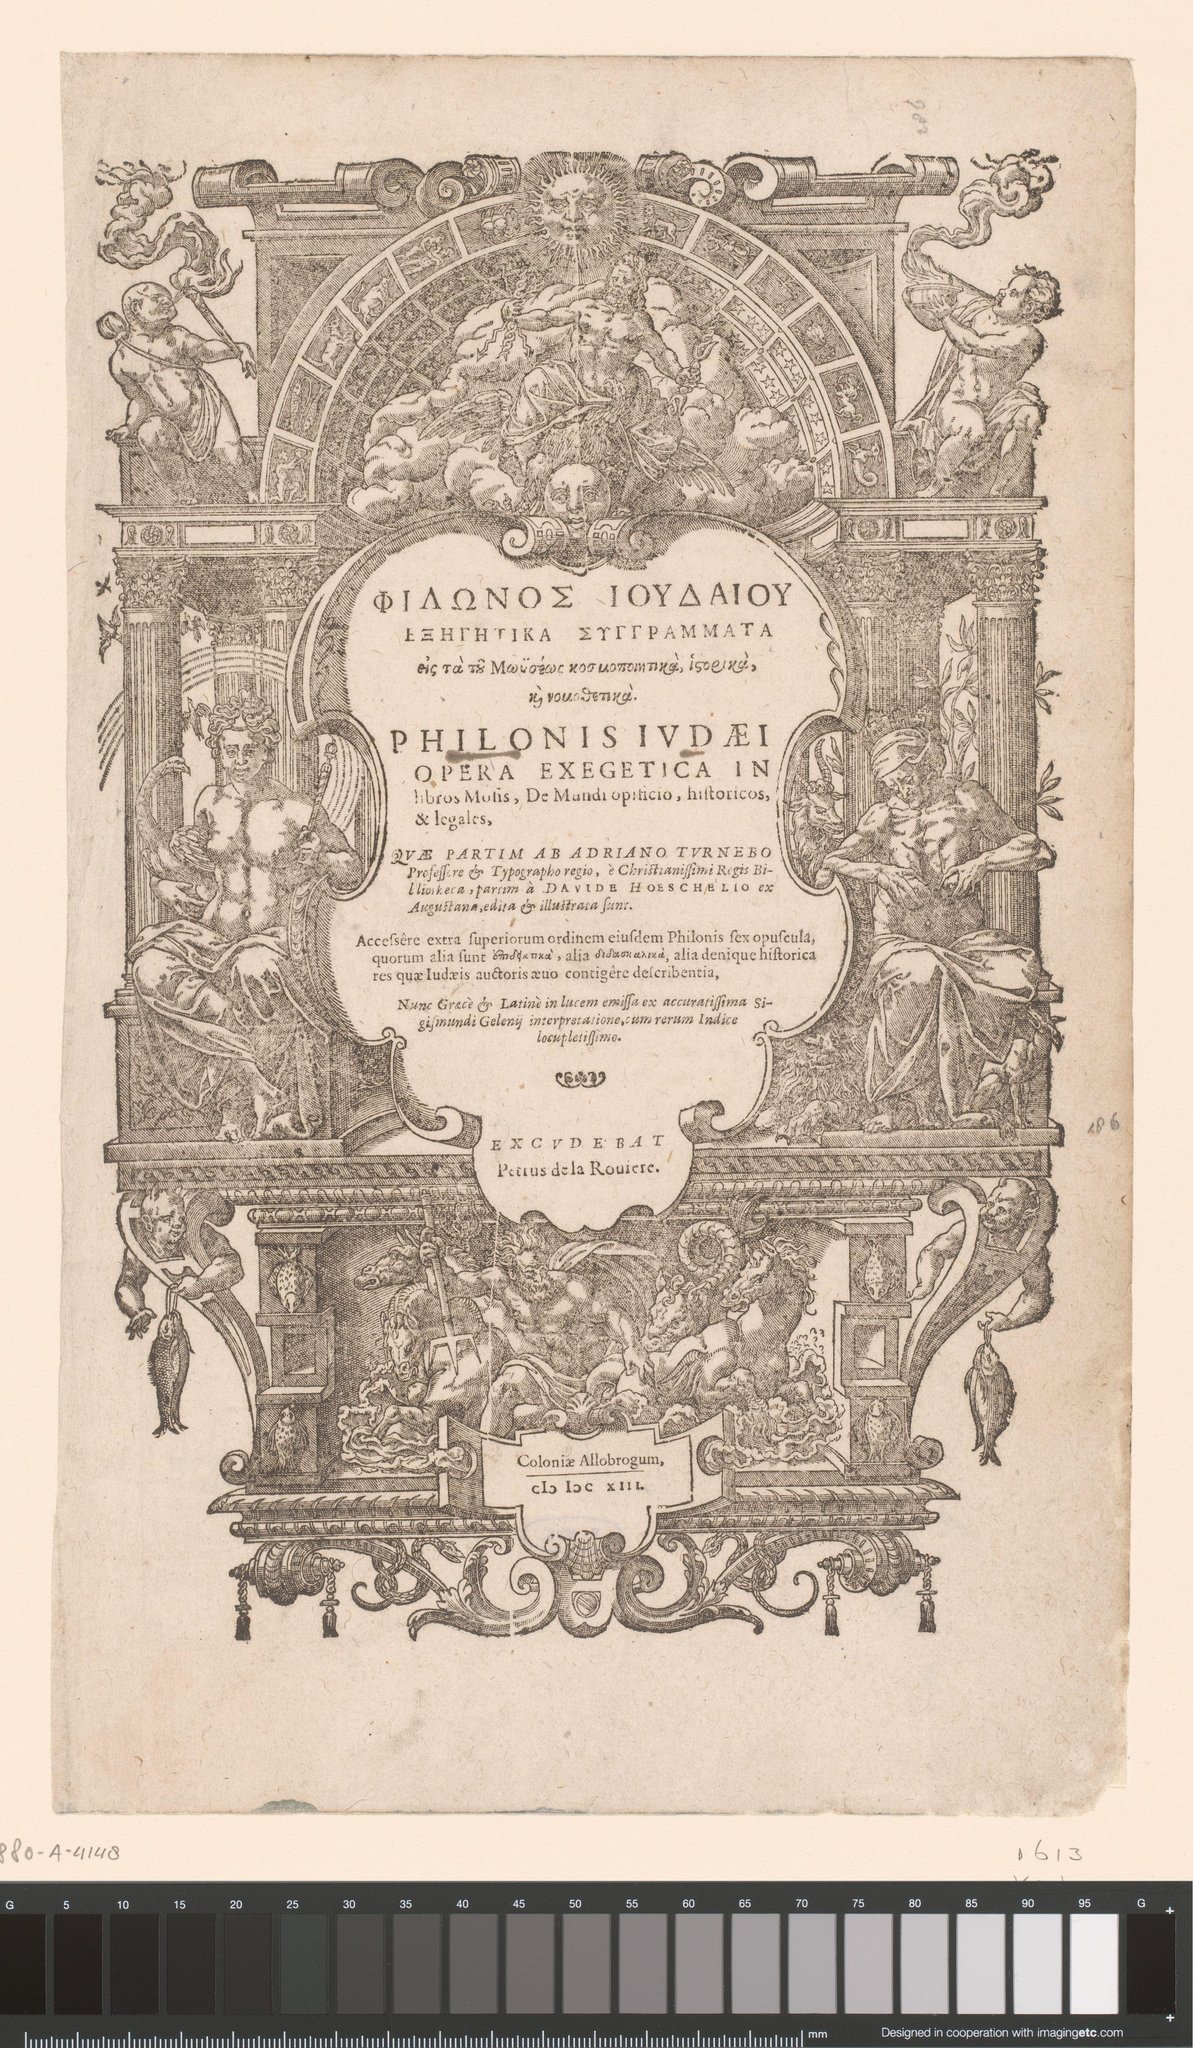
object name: print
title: Titelpagina voor: Philo van Alexandrië, Philonis Judaei Opera exegetica (...), 1613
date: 1613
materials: paper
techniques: letterpress printing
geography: geneva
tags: abstract ideas and concepts (+ allegorical scene, i.e. two or more personifications involved in an action), title-page, ornament derived from architectural details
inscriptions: collector's mark: Lugt 2228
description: Titelpagina voor: Alexandrië, Philo van. Philonis Judaei Opera exegetica (...). Genève: Petrus de la Rouiere, 1613.